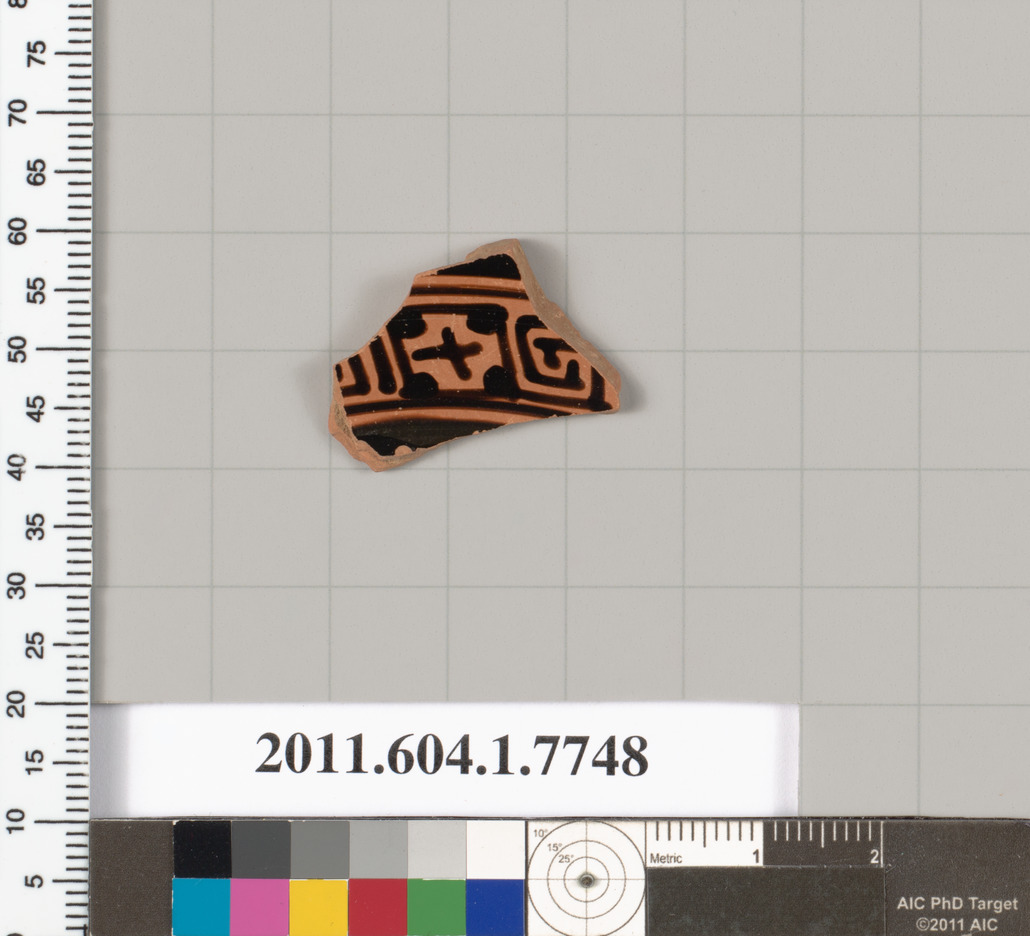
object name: kylix fragment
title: Terracotta fragment of a kylix (drinking cup)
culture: greek, attic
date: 460-450 BCE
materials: terracotta